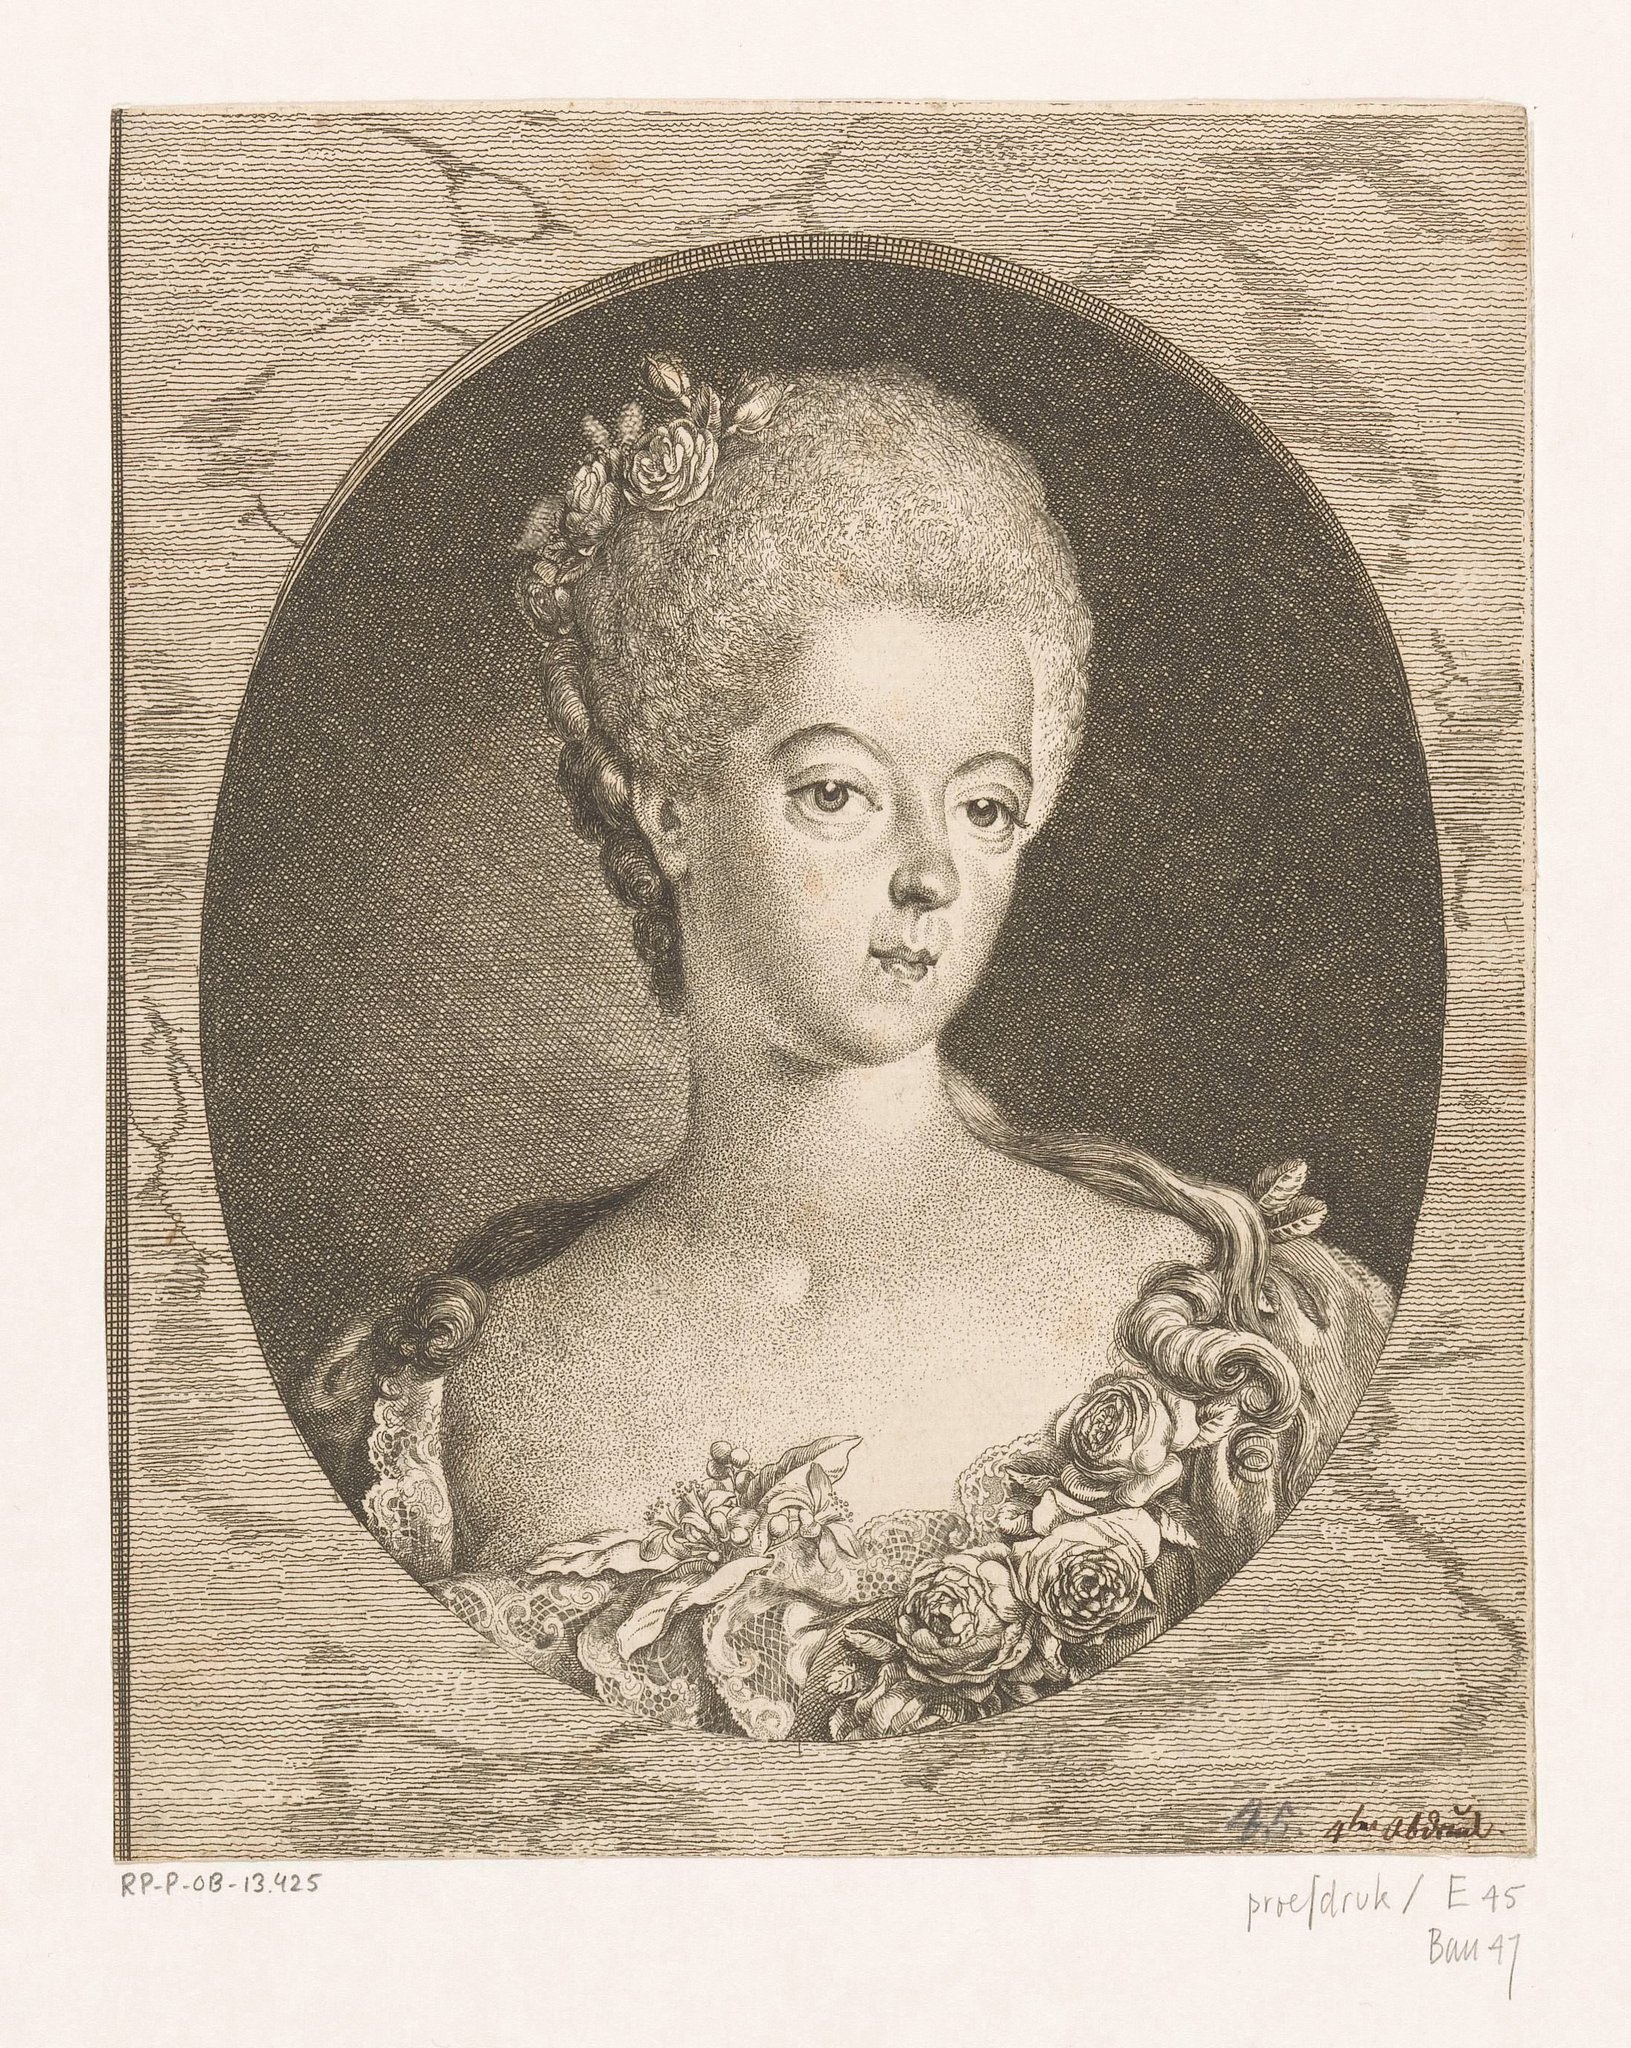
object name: print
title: Portret van Wilhelmina van Pruisen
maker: daniel nikolaus chodowiecki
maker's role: draughtsman, print maker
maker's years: 1726-1801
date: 1767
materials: paper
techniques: etching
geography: berlin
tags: painter, wilhelmina of prussia (princess of orange), historical persons - bb - woman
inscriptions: collector's mark: Lugt 2228, inscription: ‘4ten Abdrück’